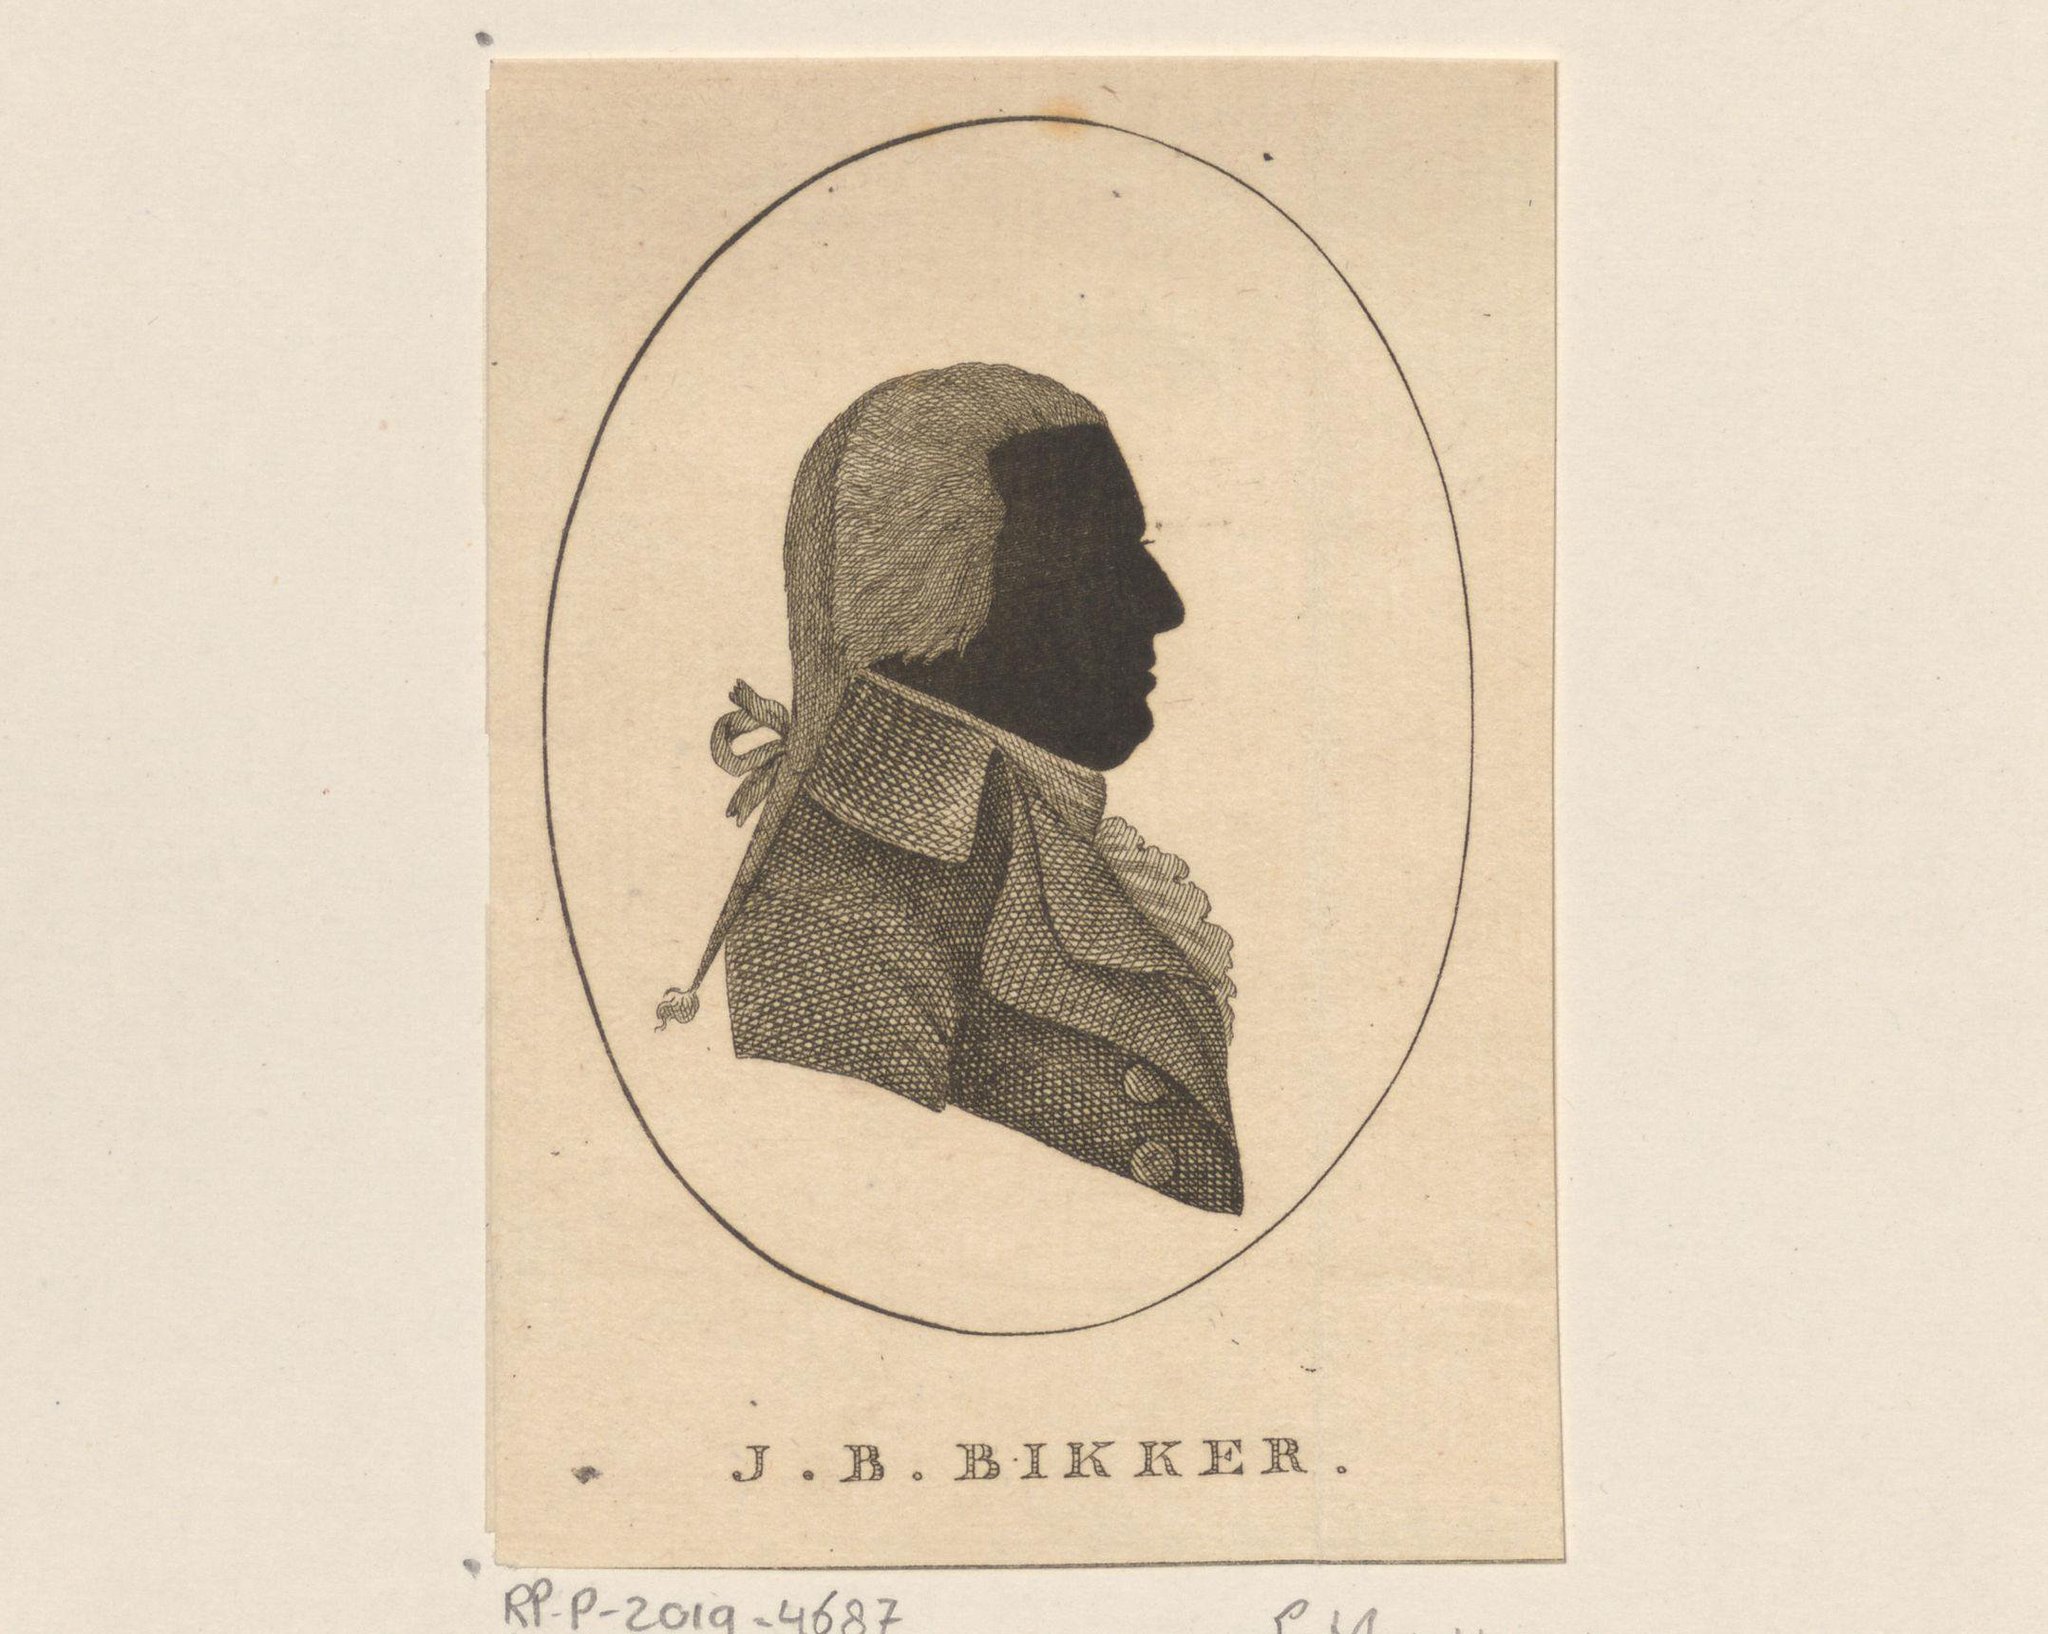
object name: book illustration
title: Silhouetportret van Jan Bernd Bicker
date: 1799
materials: paper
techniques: engraving, etching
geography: amsterdam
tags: amsterdam, the hague, historical persons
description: Prent uit: Rogge, Cornelis. Geschiedenis der staatsregeling, voor het Bataafsche volk. Amsterdam: Johannes Allart, 1799.